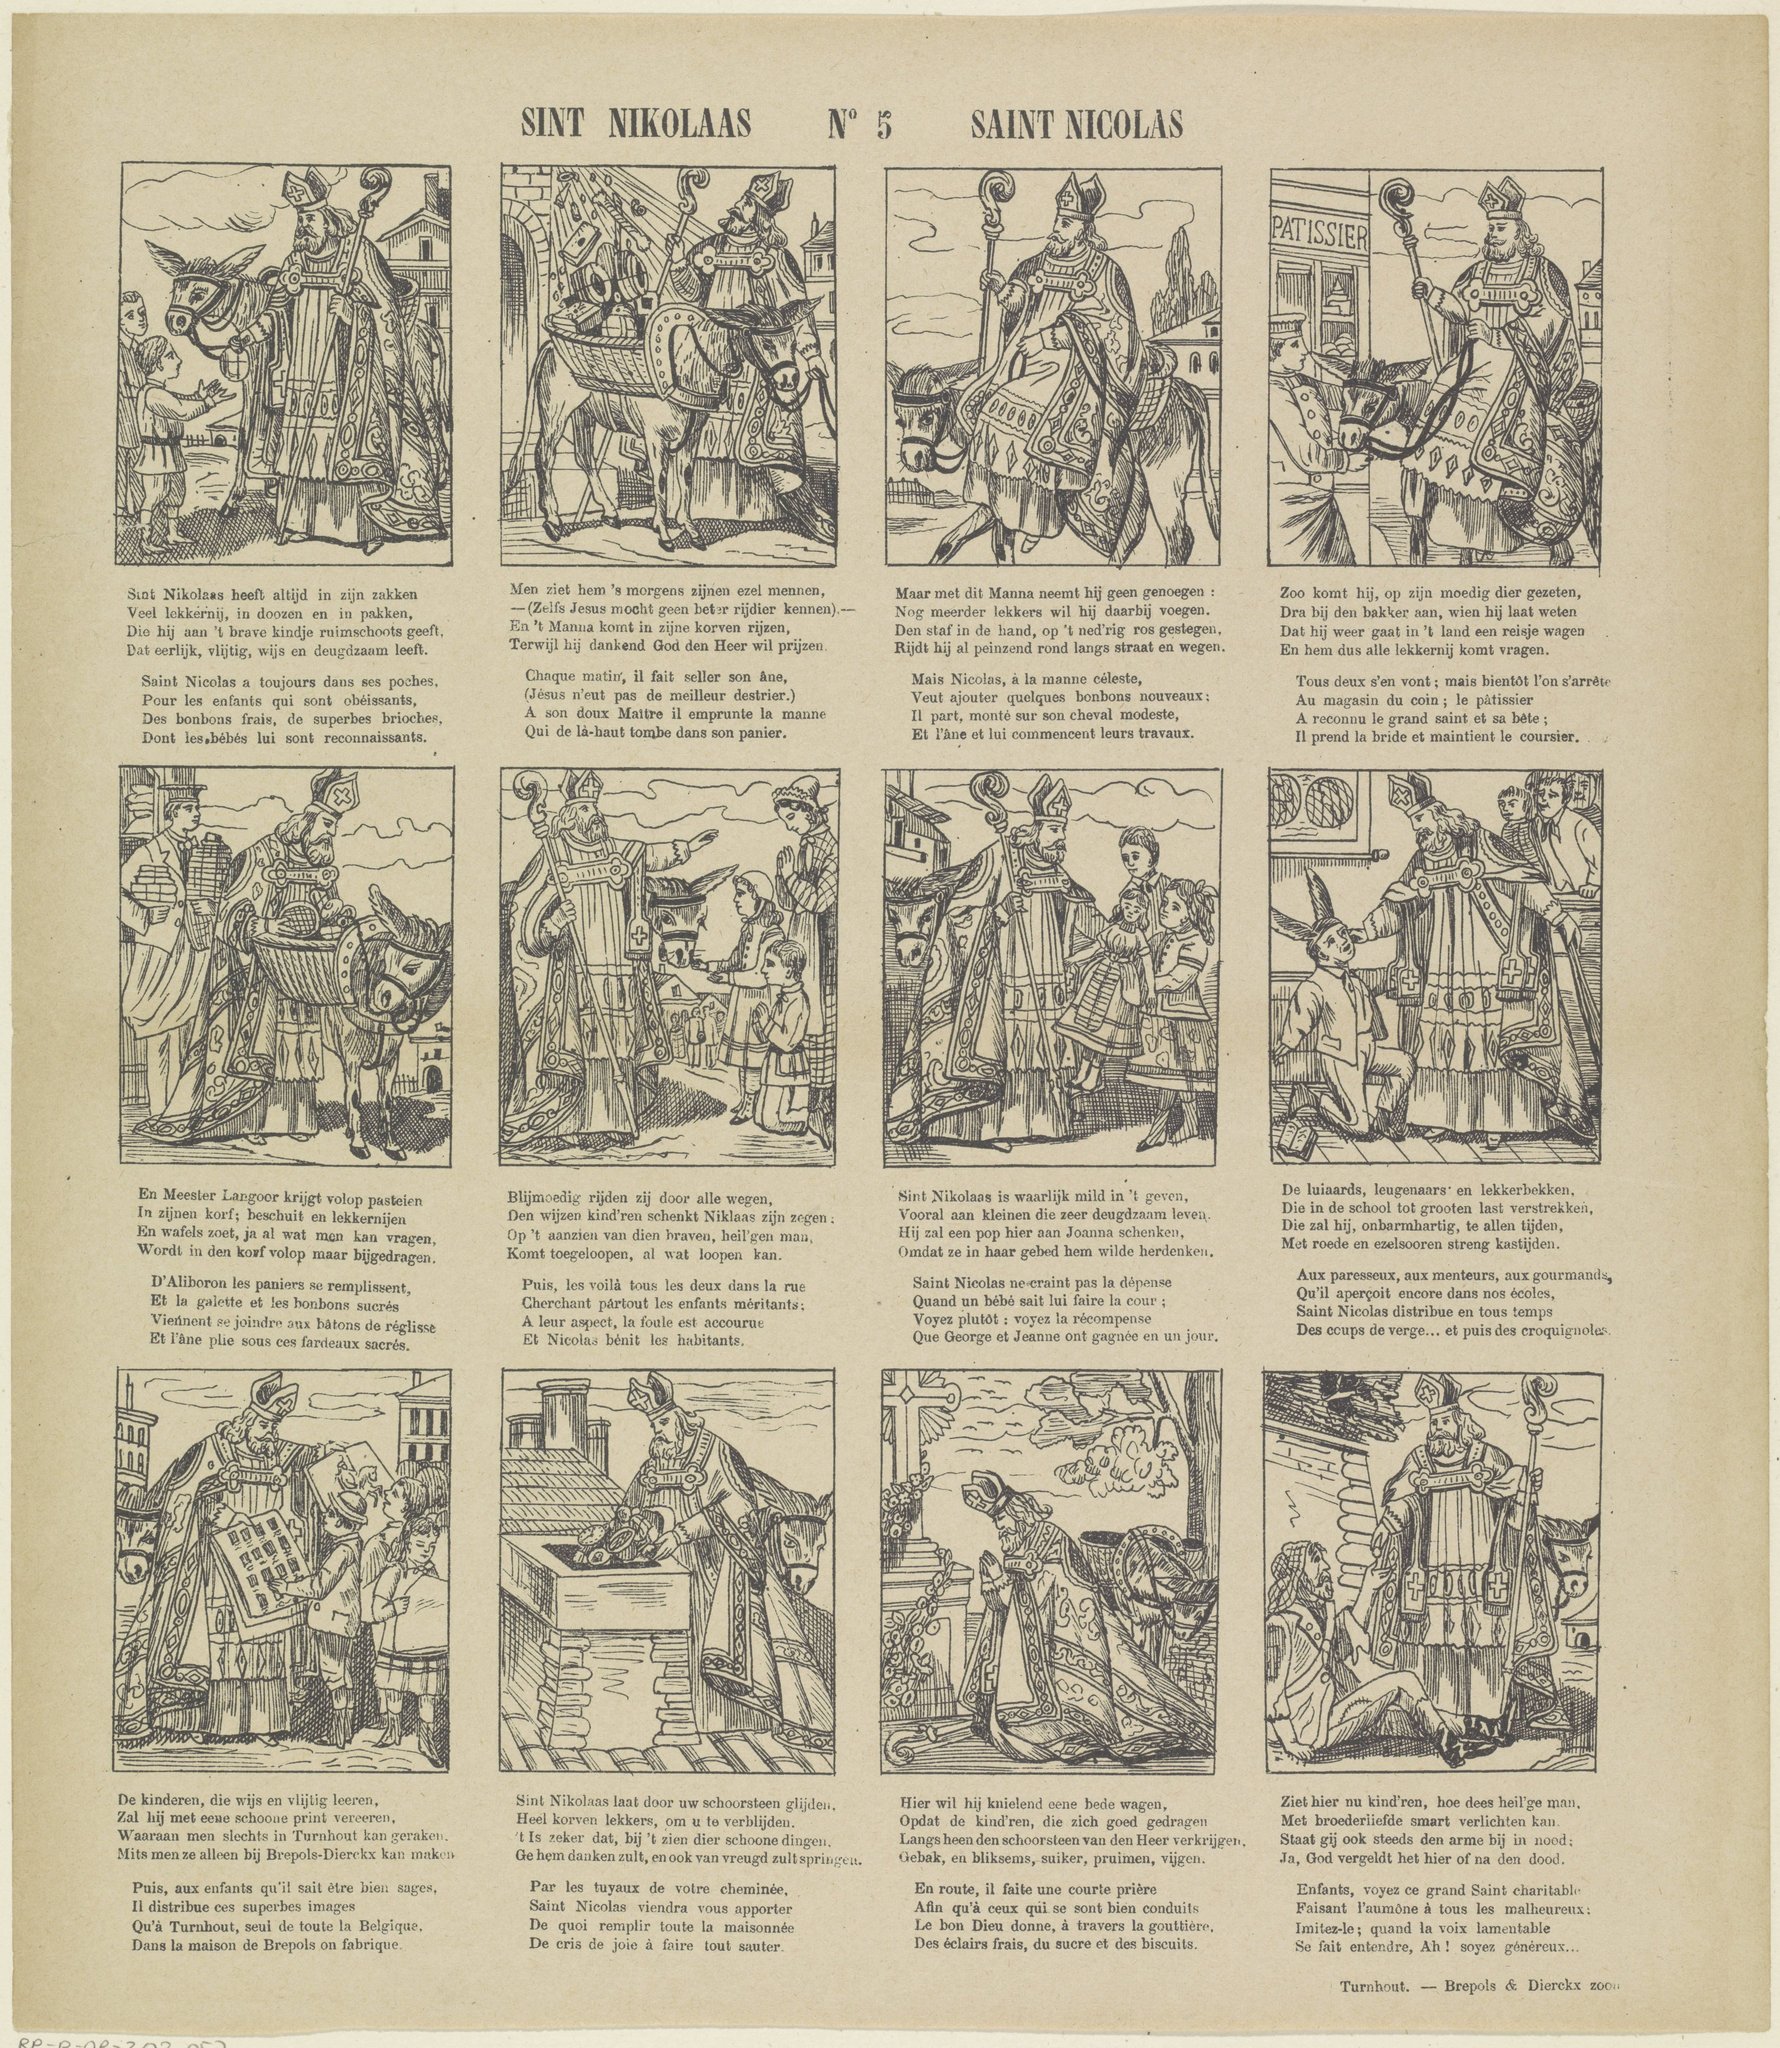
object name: popular print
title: Sint Nikolaas / Saint Nicolas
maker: Anonymous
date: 1833-1911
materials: paper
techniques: letterpress printing, lithograph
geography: turnhout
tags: the bishop nicholas of myra (or bari); possible attributes: anchor, boat, three golden balls (on a book), three purses, three children in a tub, three maidens, festivities on st. nicholas (eve) (december 5)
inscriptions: collector's mark: Lugt 2760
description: Blad met 12 voorstellingen over de feestdag van Sint Nicolaas. Onder elke afbeelding een vierregelig vers in het Nederlands en in het Frans. Genummerd midden boven: No 5.